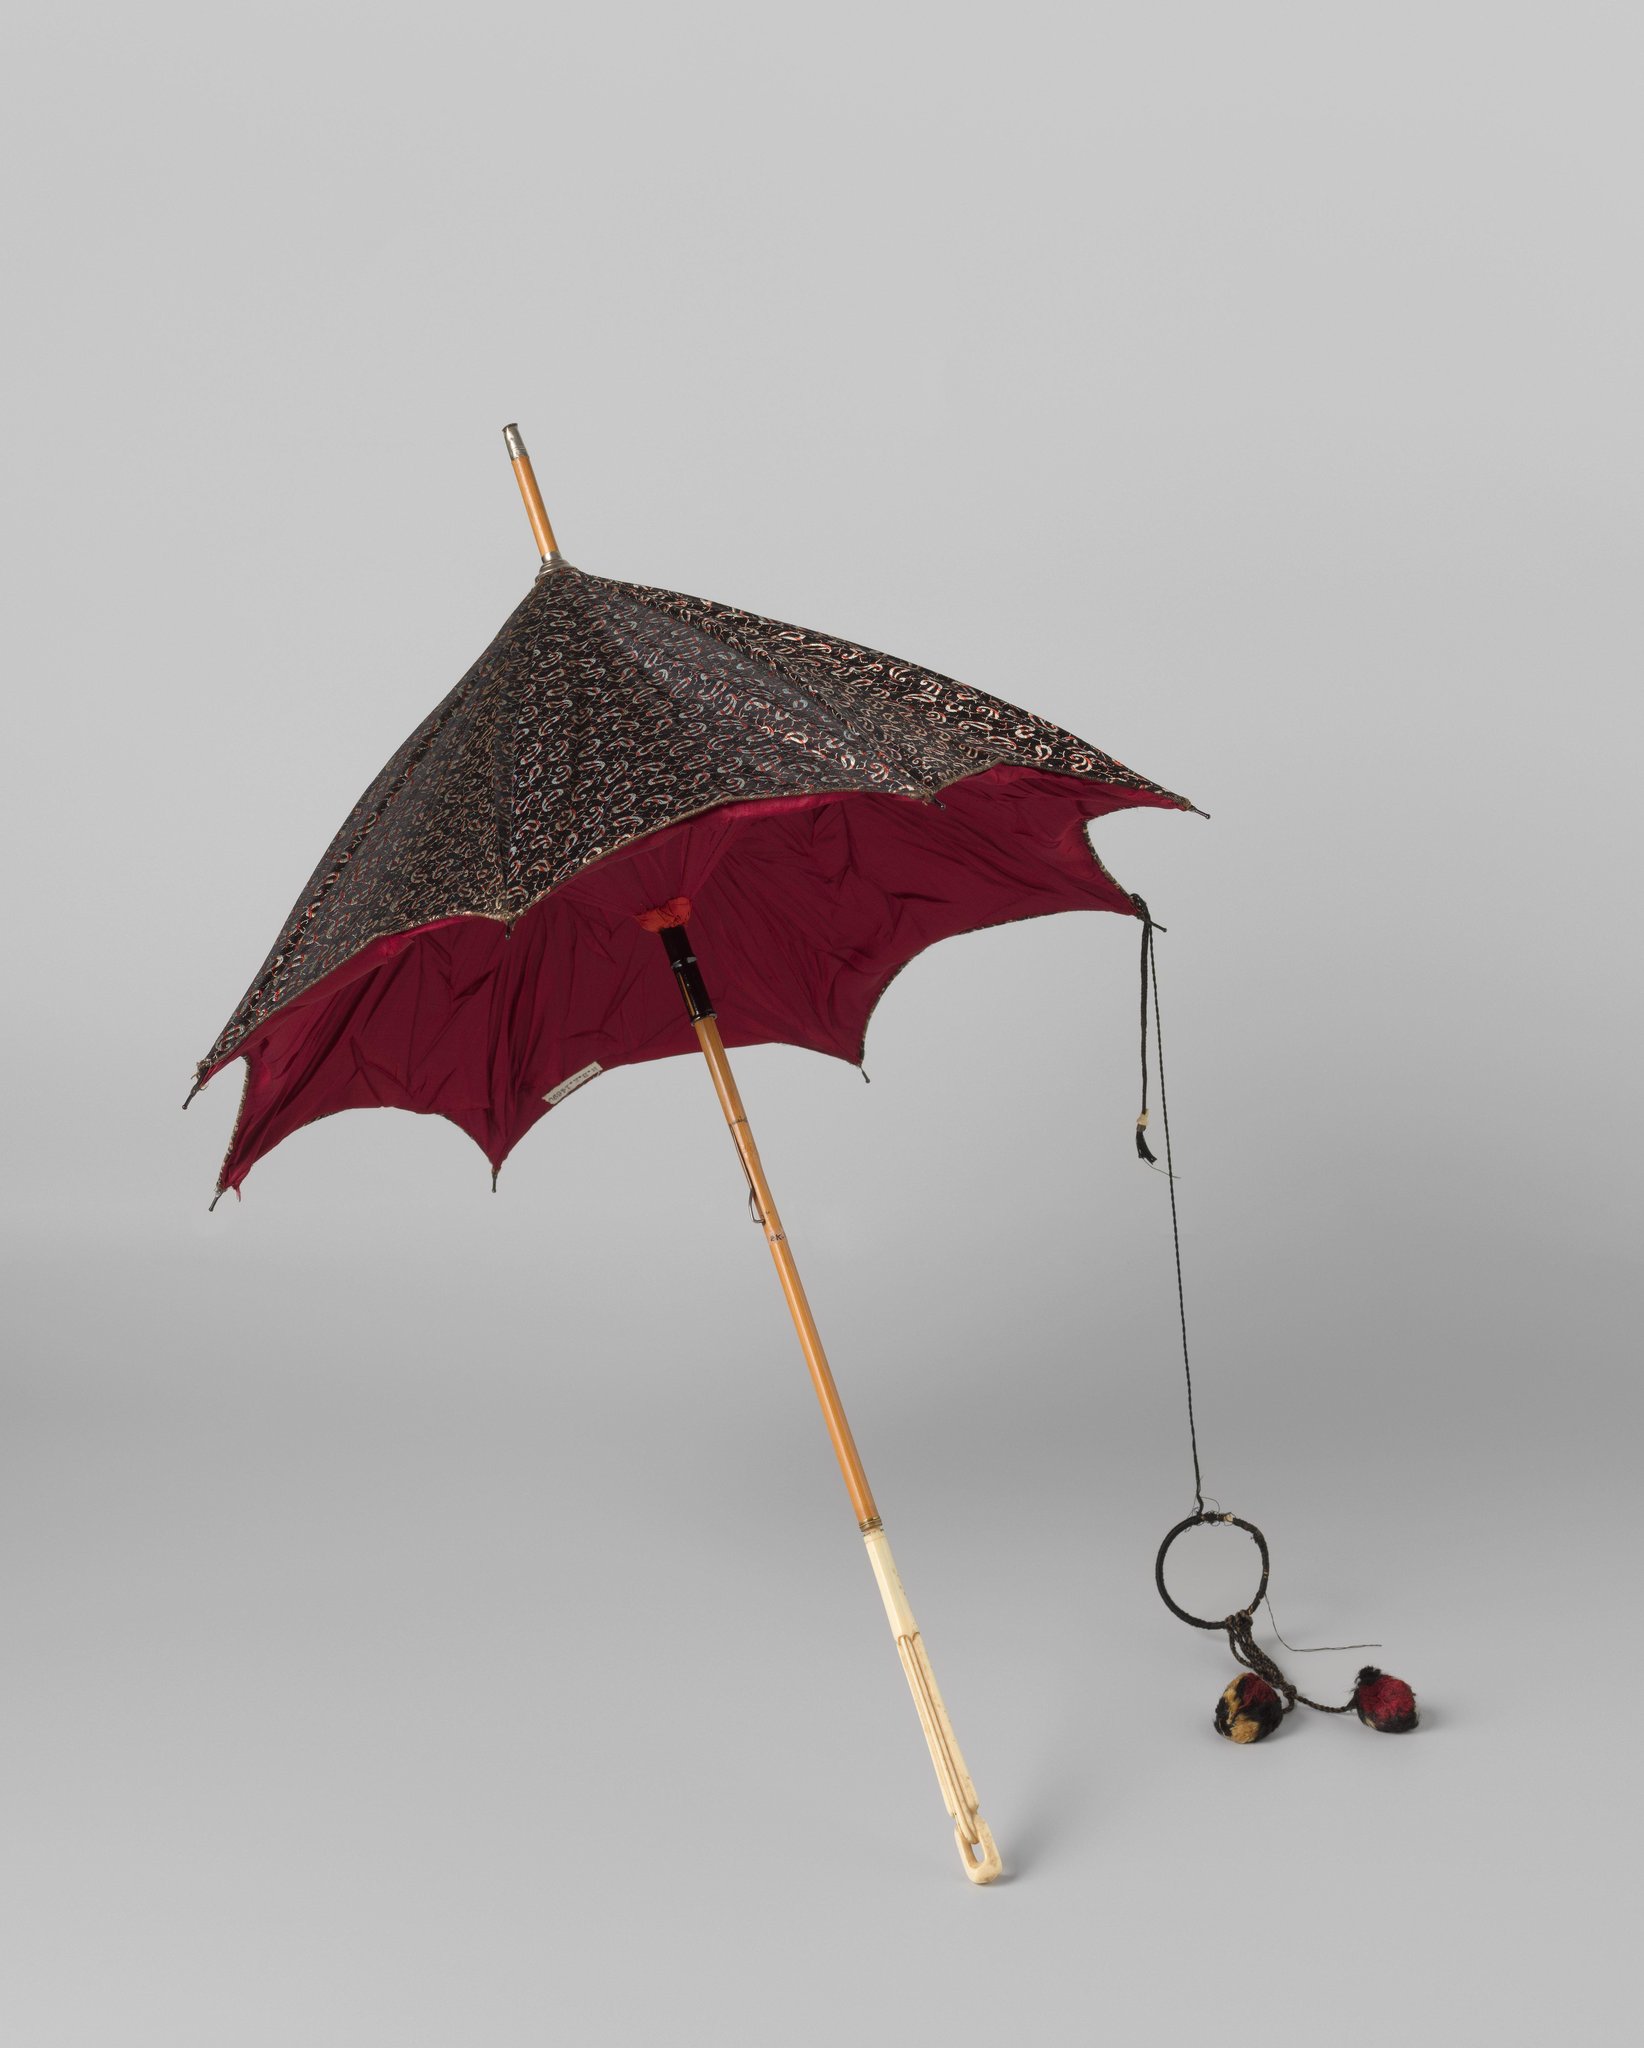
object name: parasol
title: Parasol met dek van zwarte zijde met strooimotief van witte botahs en rode strepen, gevoerd met donkerrode zijde, op dunne bamboe stok met gesneden ivoren handvat en metalen punt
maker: Anonymous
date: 1890-1900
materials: bamboo, ivory, silk, steel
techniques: cutting, weave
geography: göteborg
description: Parasol met dek van zwarte zijde met strooimotief van witte botahs en rode strepen, gevoerd met donkerrode zijde, op dunne bamboe stok met gesneden ivoren handvat en metalen punt. Baleinen van zwart gelakt staal. Sluiting door middel van smal zwart elastiek met ivoren ornamentje dat achter een dubbele kopren haak gehaakt wordt. Gedraaid zijden koord met dito ring en twee zijden pompons. Het ivoren handvat is gecanneleerd en heeft een gesneden ring aan het uiteiende.